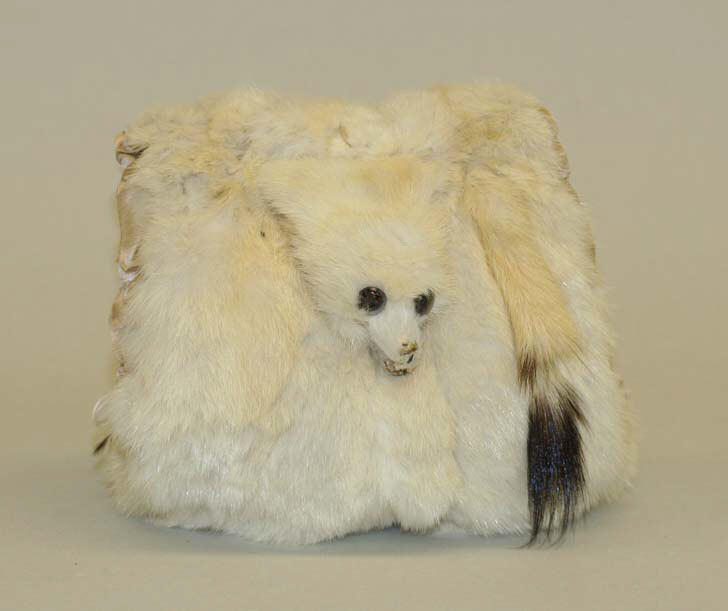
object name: muff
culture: american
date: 1899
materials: fur